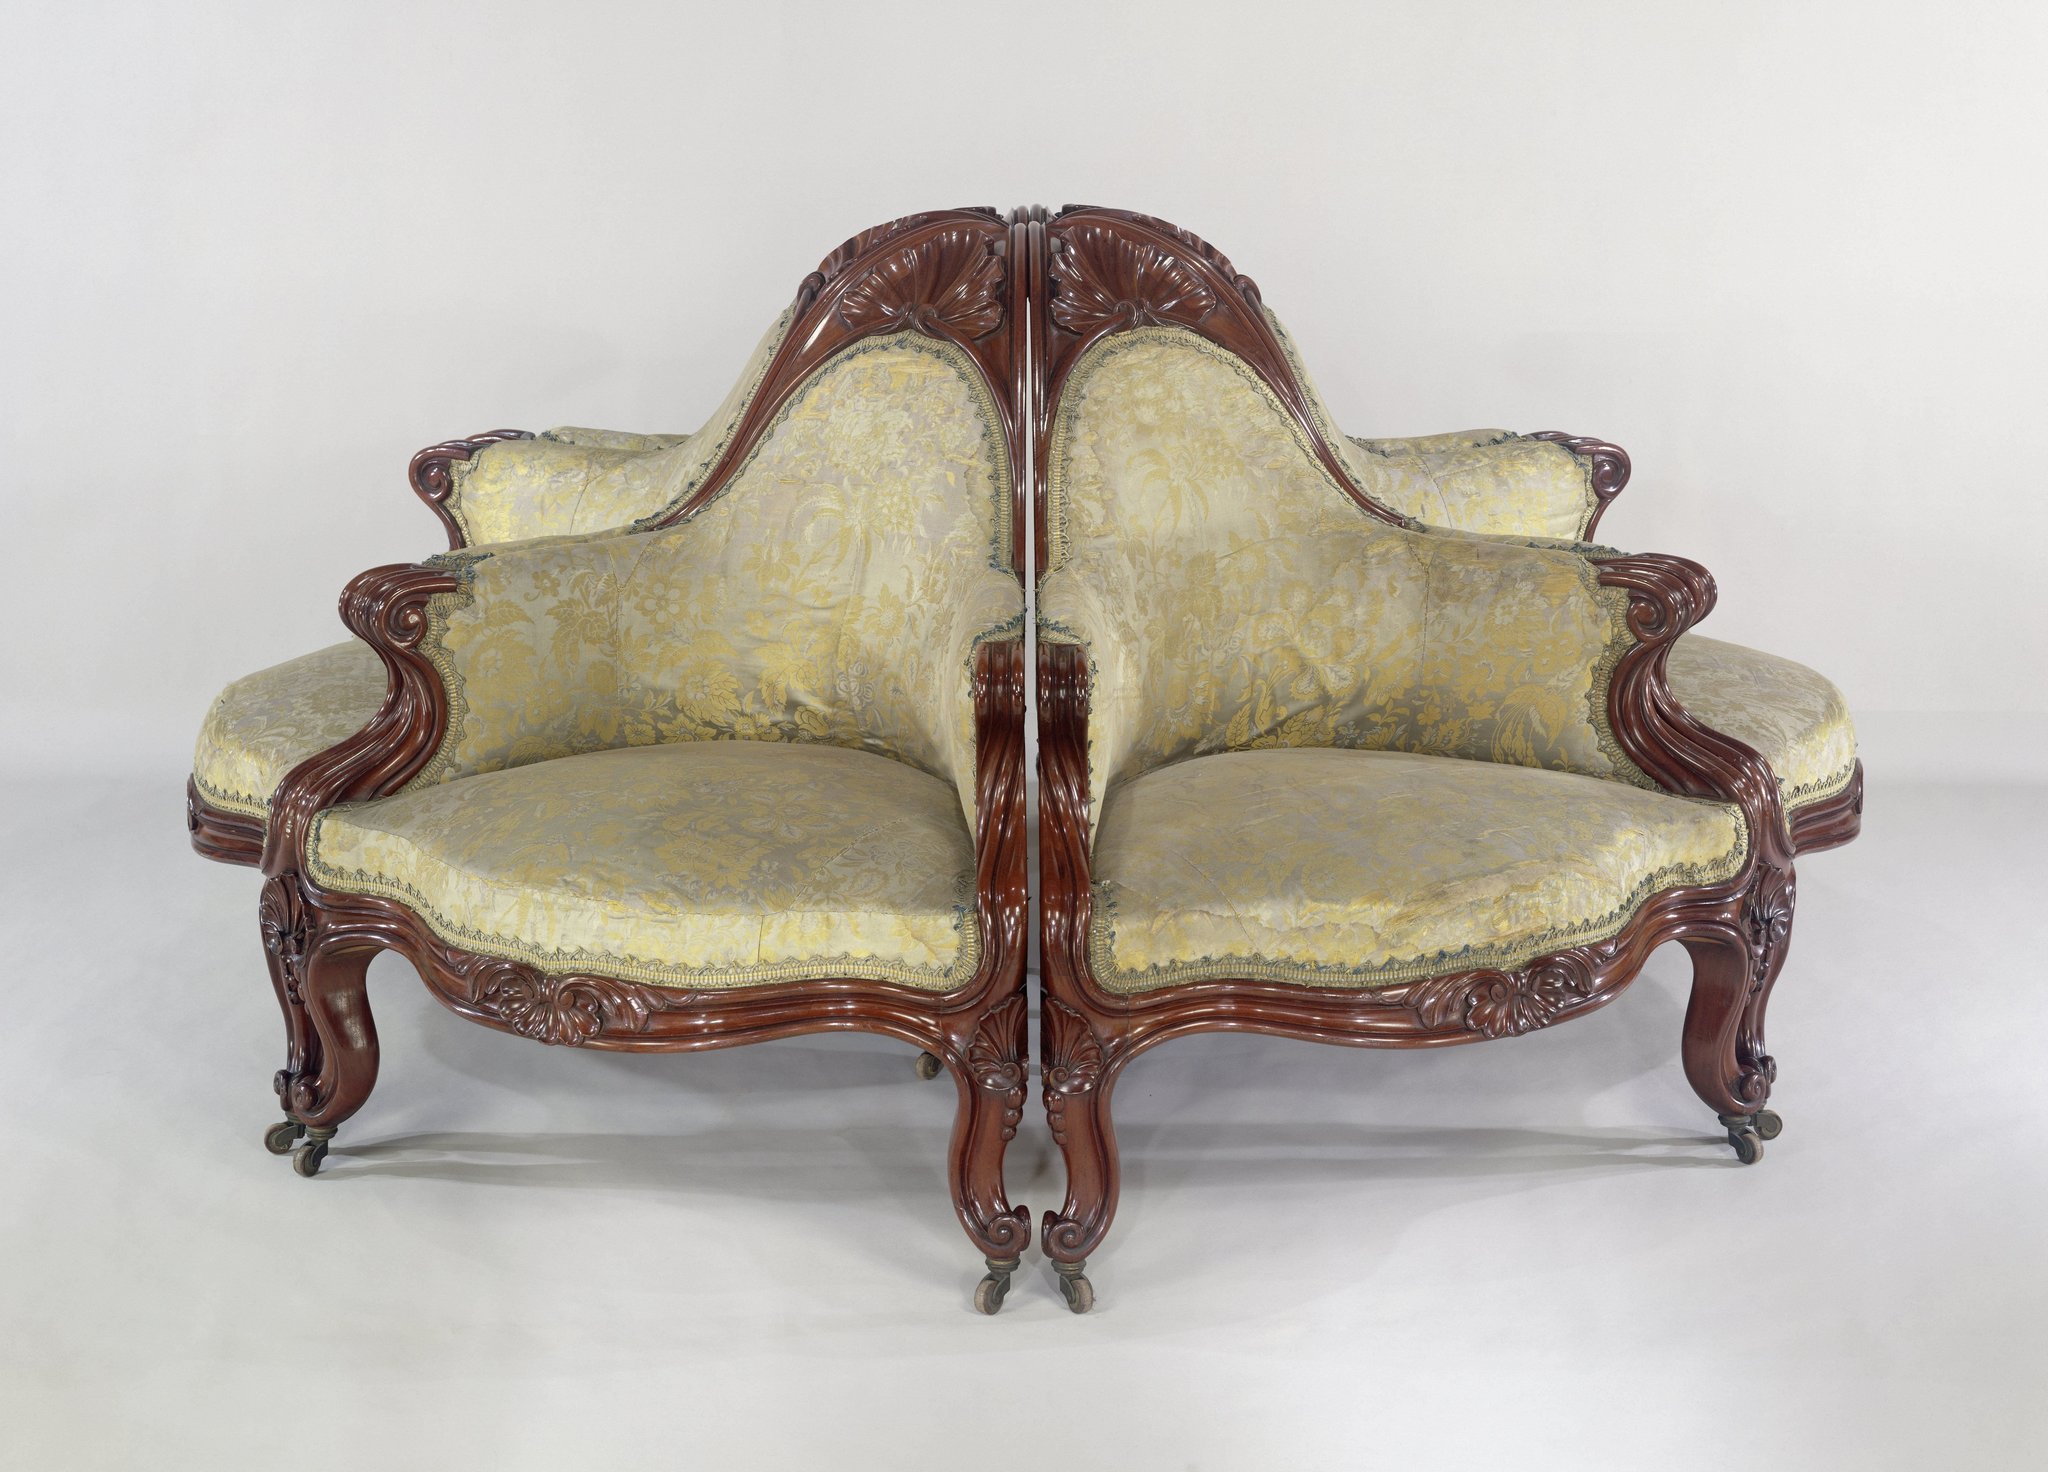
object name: furniture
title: Armstoel, onderdeel van een divan de milieu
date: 1852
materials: wood, silk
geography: the hague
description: Divan de milieu. Mahogany, upholstered with silk lampas. The Hague, c. 1852, by the Horrix Brothers. The lampas France. The divan de milieu, which retains its original upholstery, was made for Prince Frederik of The Netherlands.